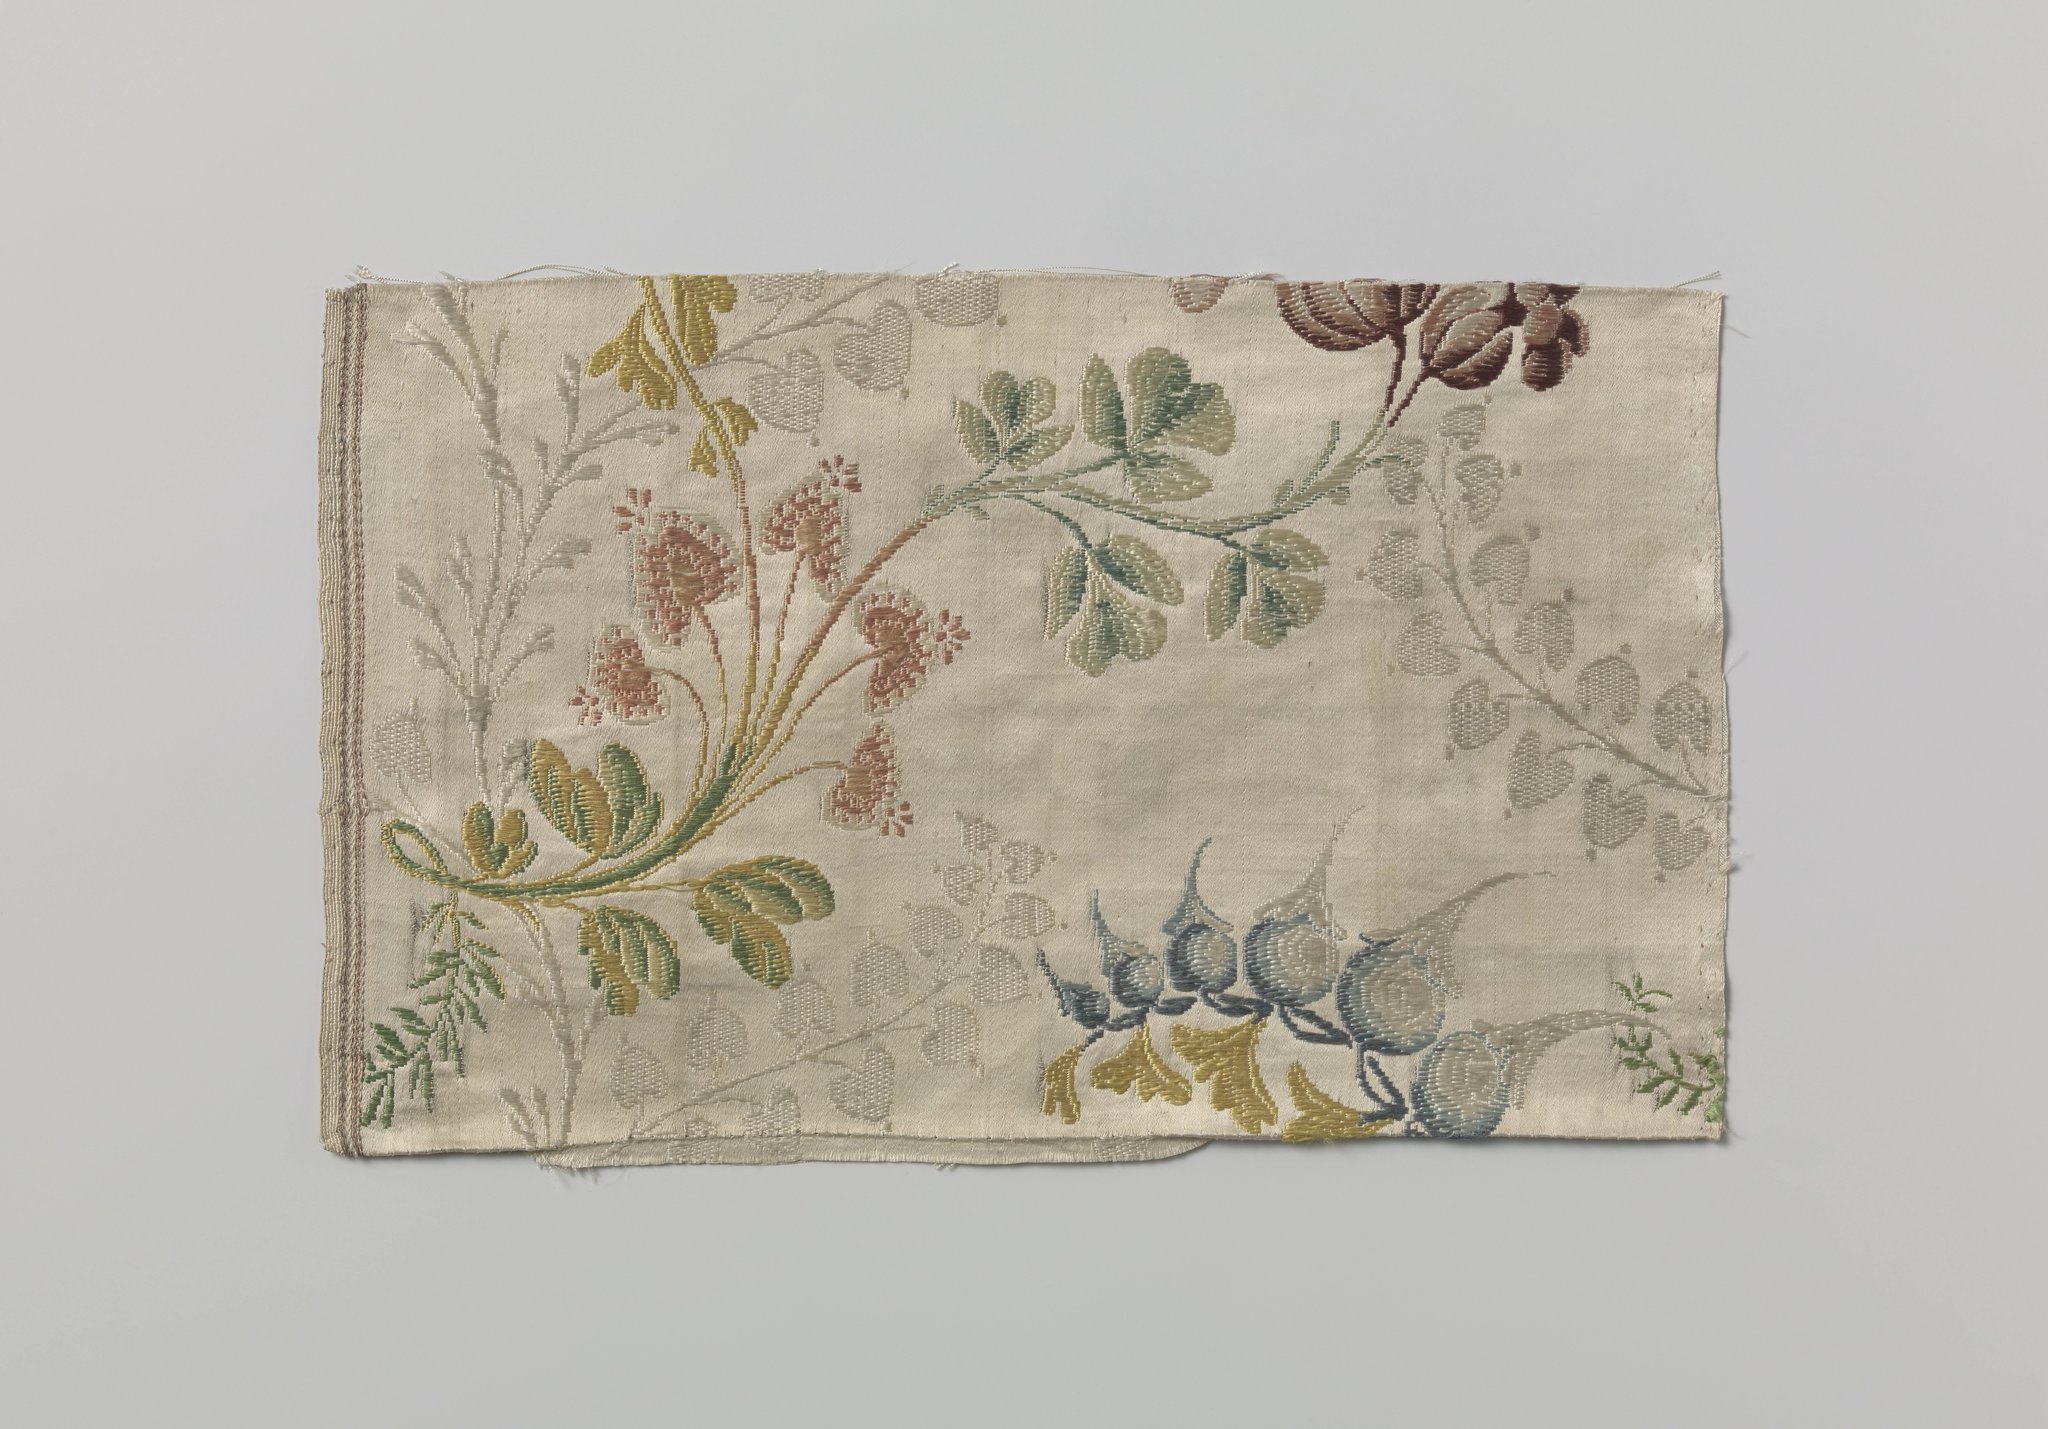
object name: zijdesatijn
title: Fragment veelkleurig zijdesatijn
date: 1730-1760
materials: silk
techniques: brocade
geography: netherlands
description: Twee fragmenten van veelkleurig zijdeweefsel. Het patroon heeft witte bladranken met hartvormige bladeren en veelkleurige bloemtakken.